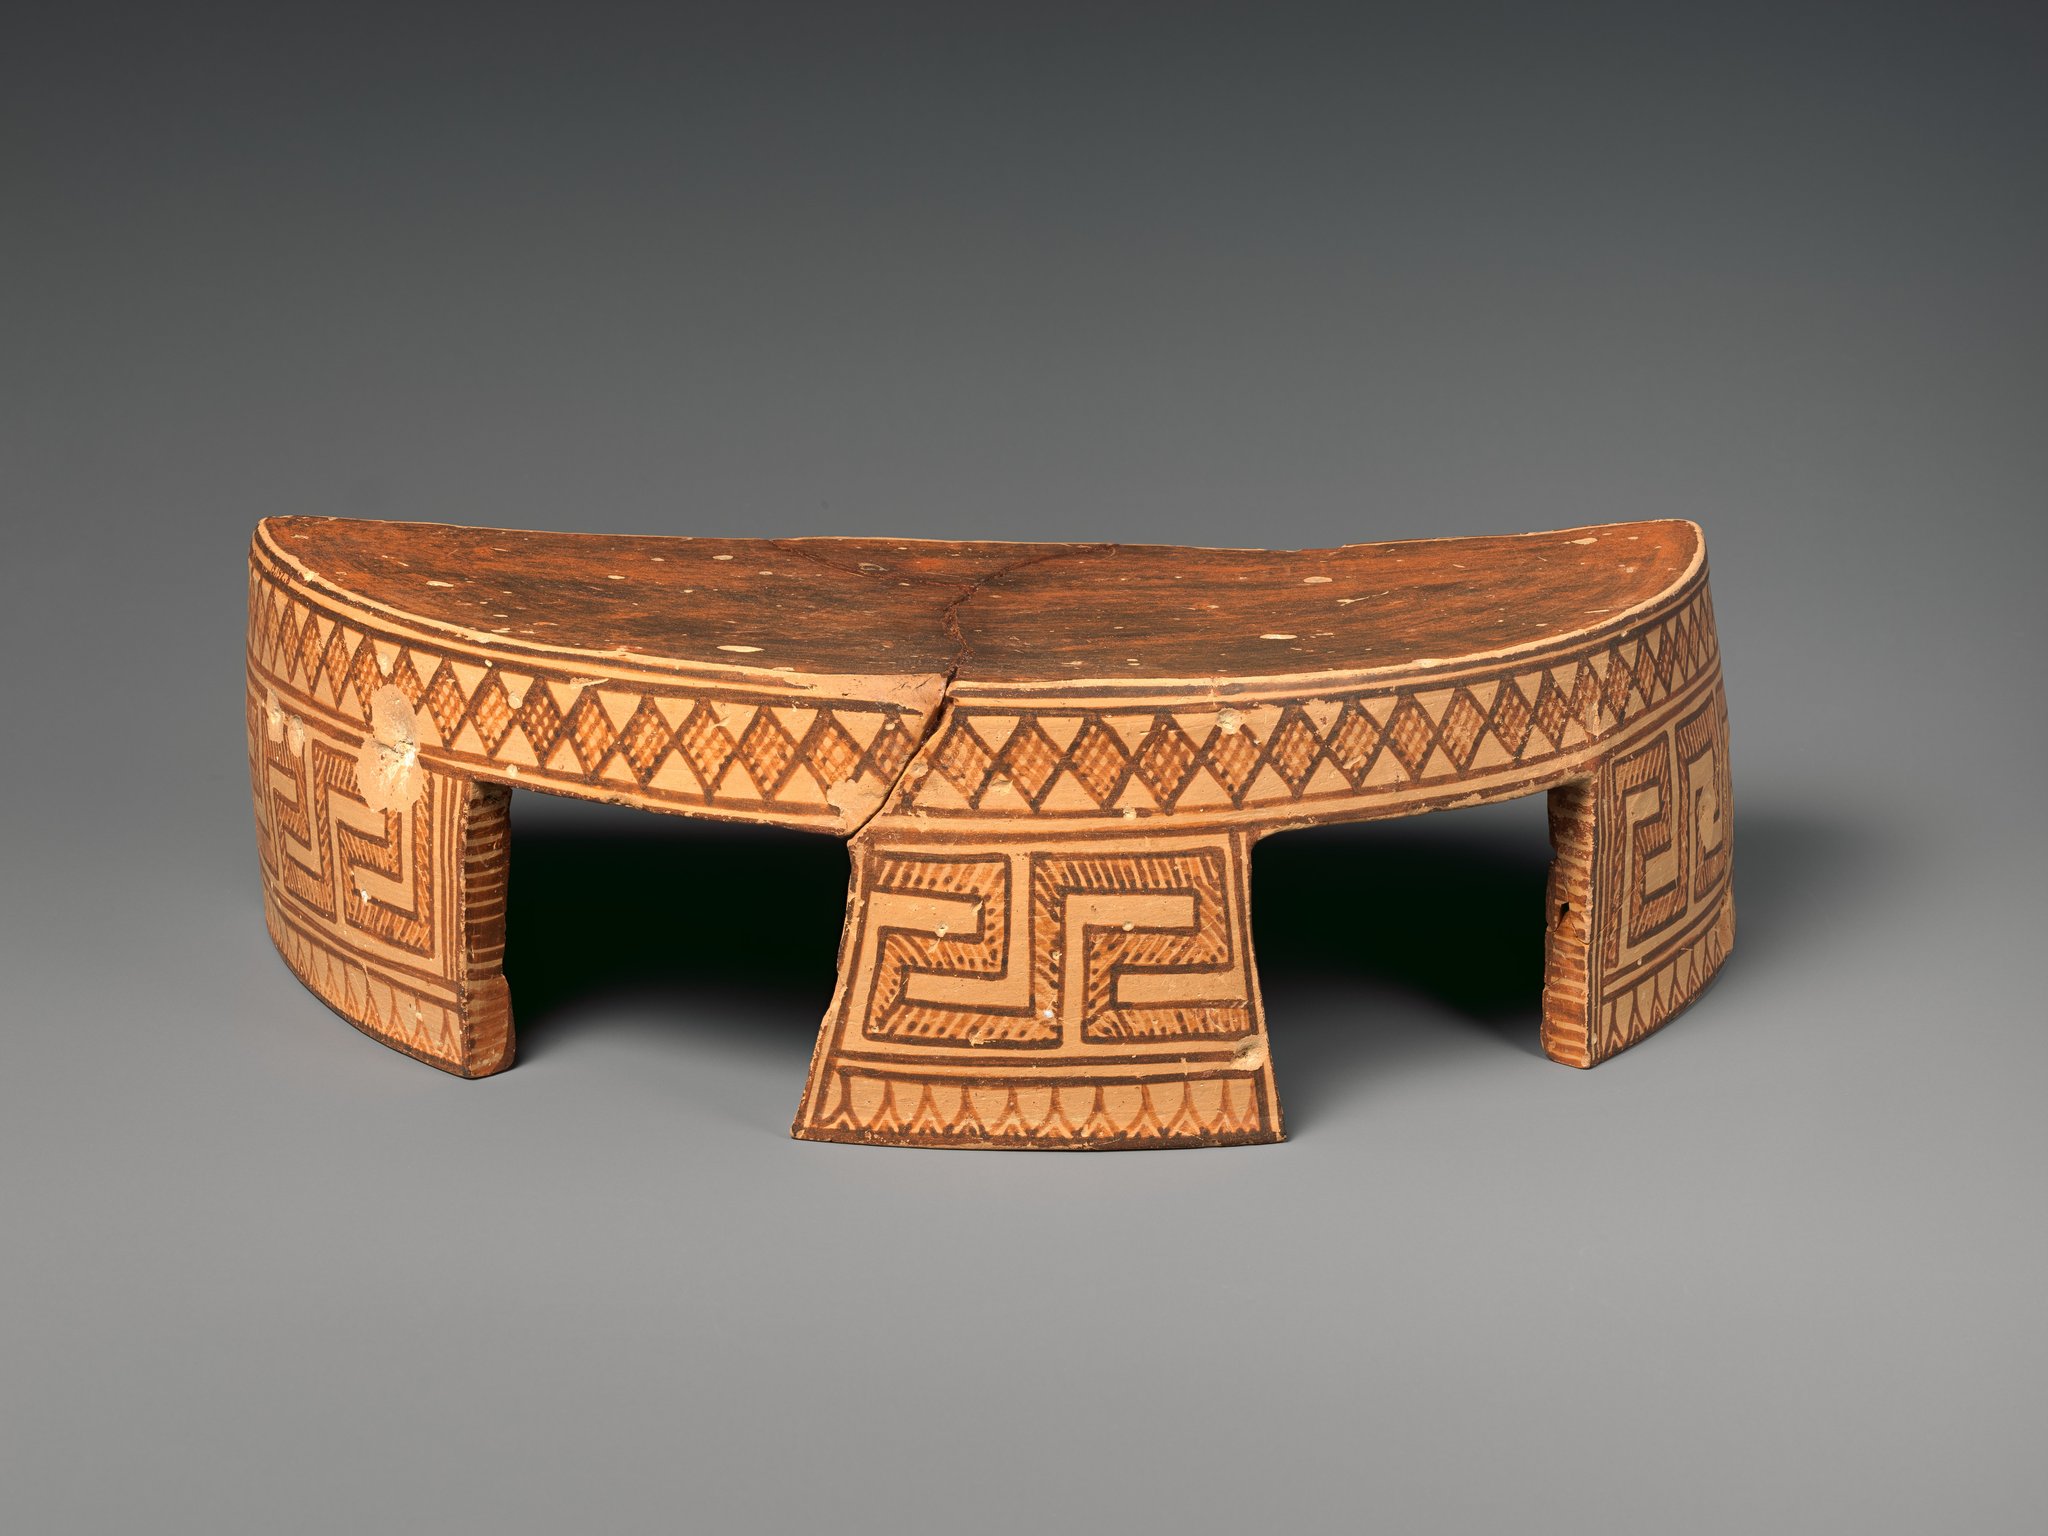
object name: stand, semicircular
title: Terracotta semicircular stand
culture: greek, attic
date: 800-701 BCE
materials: terracotta